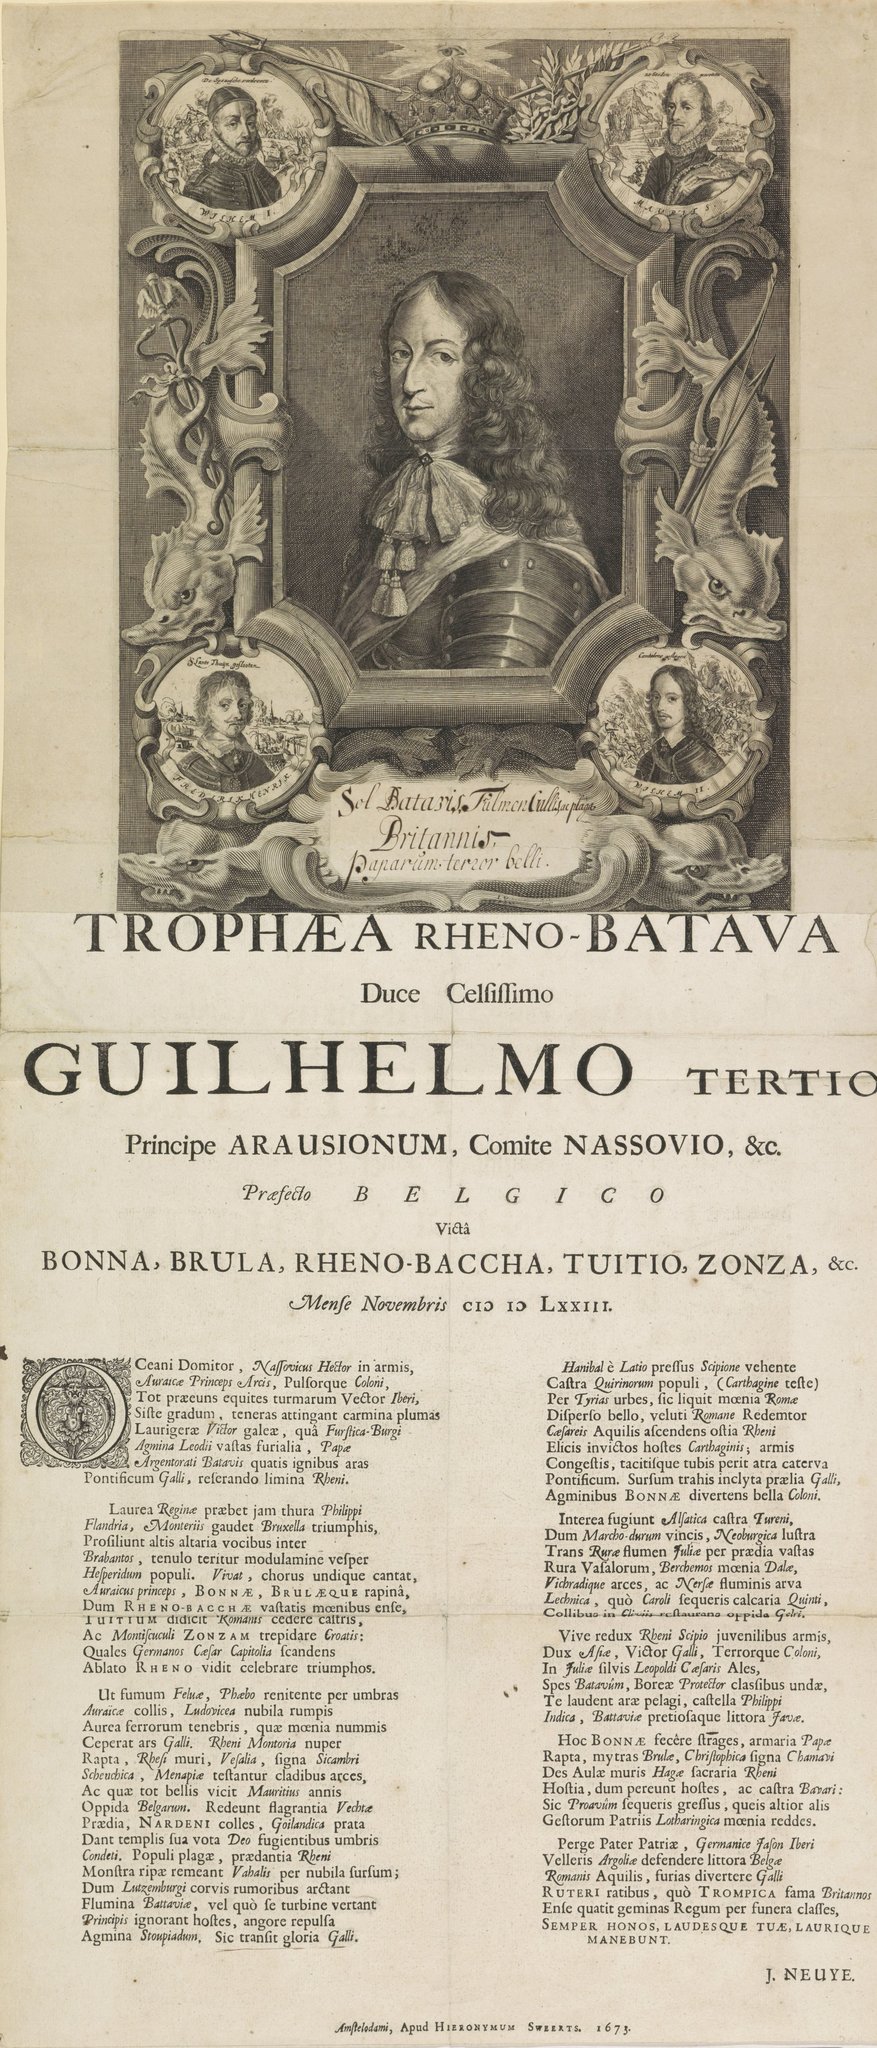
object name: print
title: Portret van Willem III, prins van Oranje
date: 1673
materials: paper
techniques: engraving, etching, letterpress printing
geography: low countries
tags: the hague, william iii (prince of orange and king of england, scotland, and ireland), frederick henry (prince of orange), william ii (prince of orange), delft, william i (prince of orange), maurice (prince of orange), rampjaar (disaster year)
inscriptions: collector's mark: Lugt 963, inscription: ‘Sol Batavis, ... belli’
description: Portret van Willem III in een achtkantige omlijsting. In de vier hoeken portretten van de vier voorgaande stadhouders Willem I, Maurits, Frederik Hendrik en Willem II. Geheel in een omlijsting met arabesken en een aantal allegorische objecten en dieren. Daaronder losse opgeplakte tekst in boekdruk over de verovering van Bonn, Rheinbach, Brühl en andere Duitse steden, 1673.